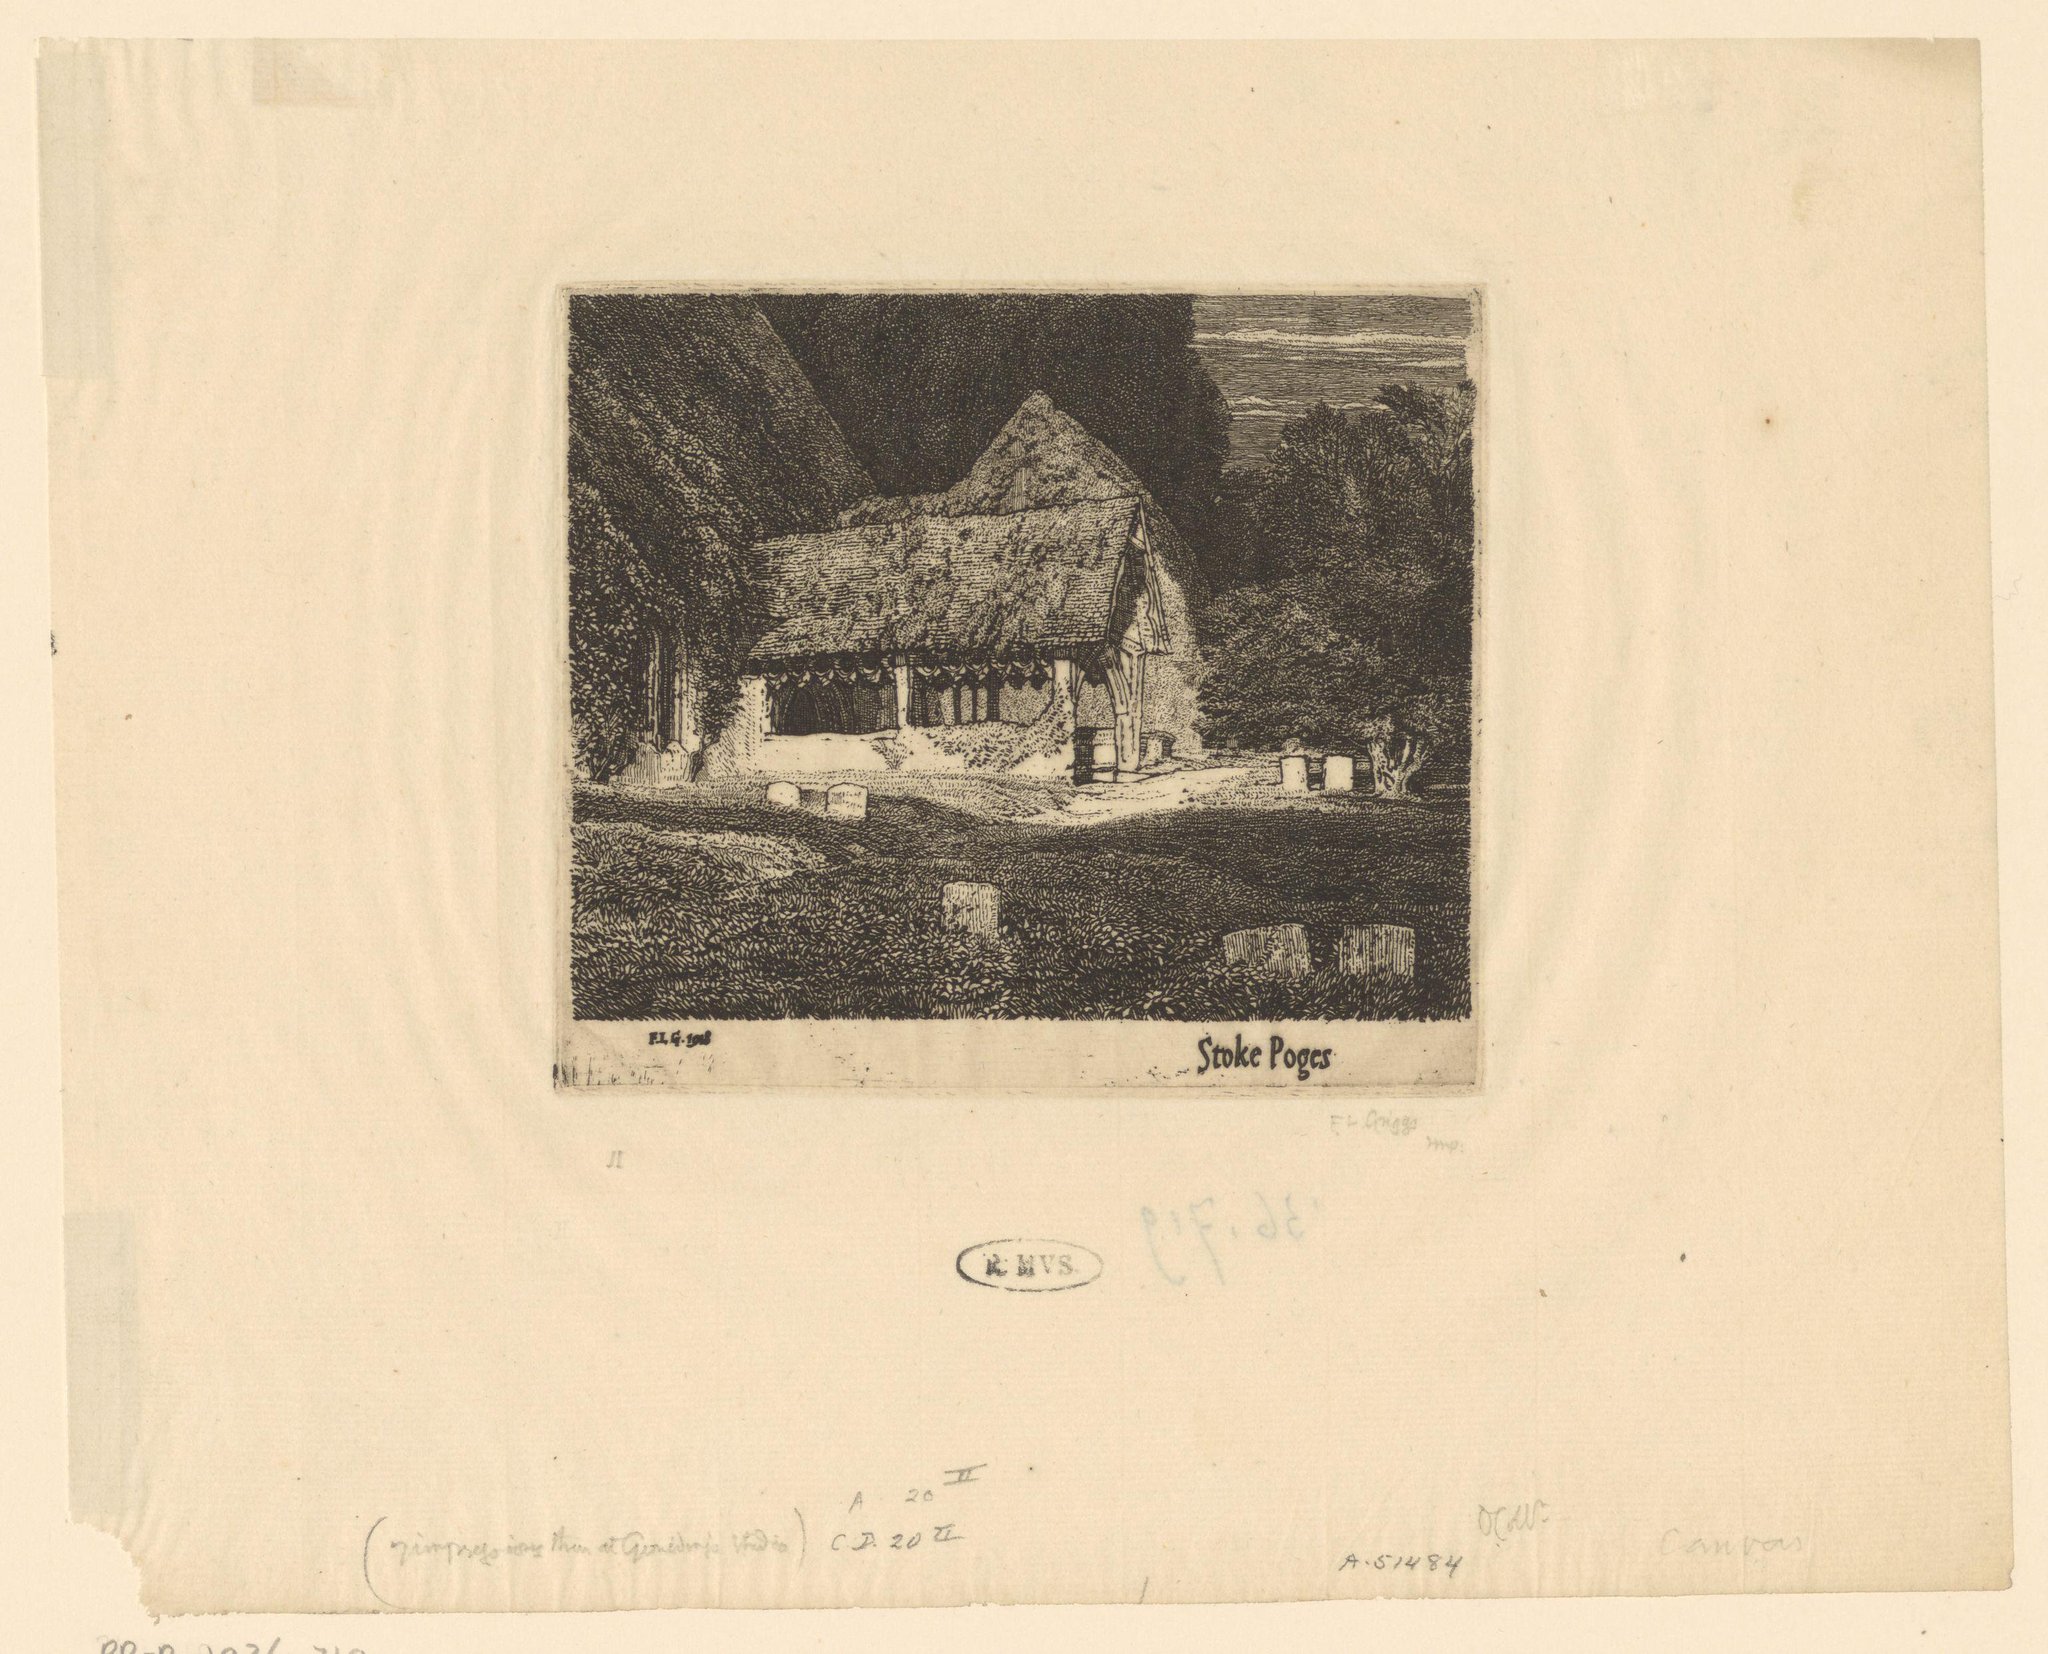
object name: print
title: Stoke Poges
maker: frederick landseer maur griggs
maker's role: print maker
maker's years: 1876-1938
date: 1918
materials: paper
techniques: etching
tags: trees: elm, church (exterior)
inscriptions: collector's mark: Lugt 2228, signature: ‘F.L. Griggs’